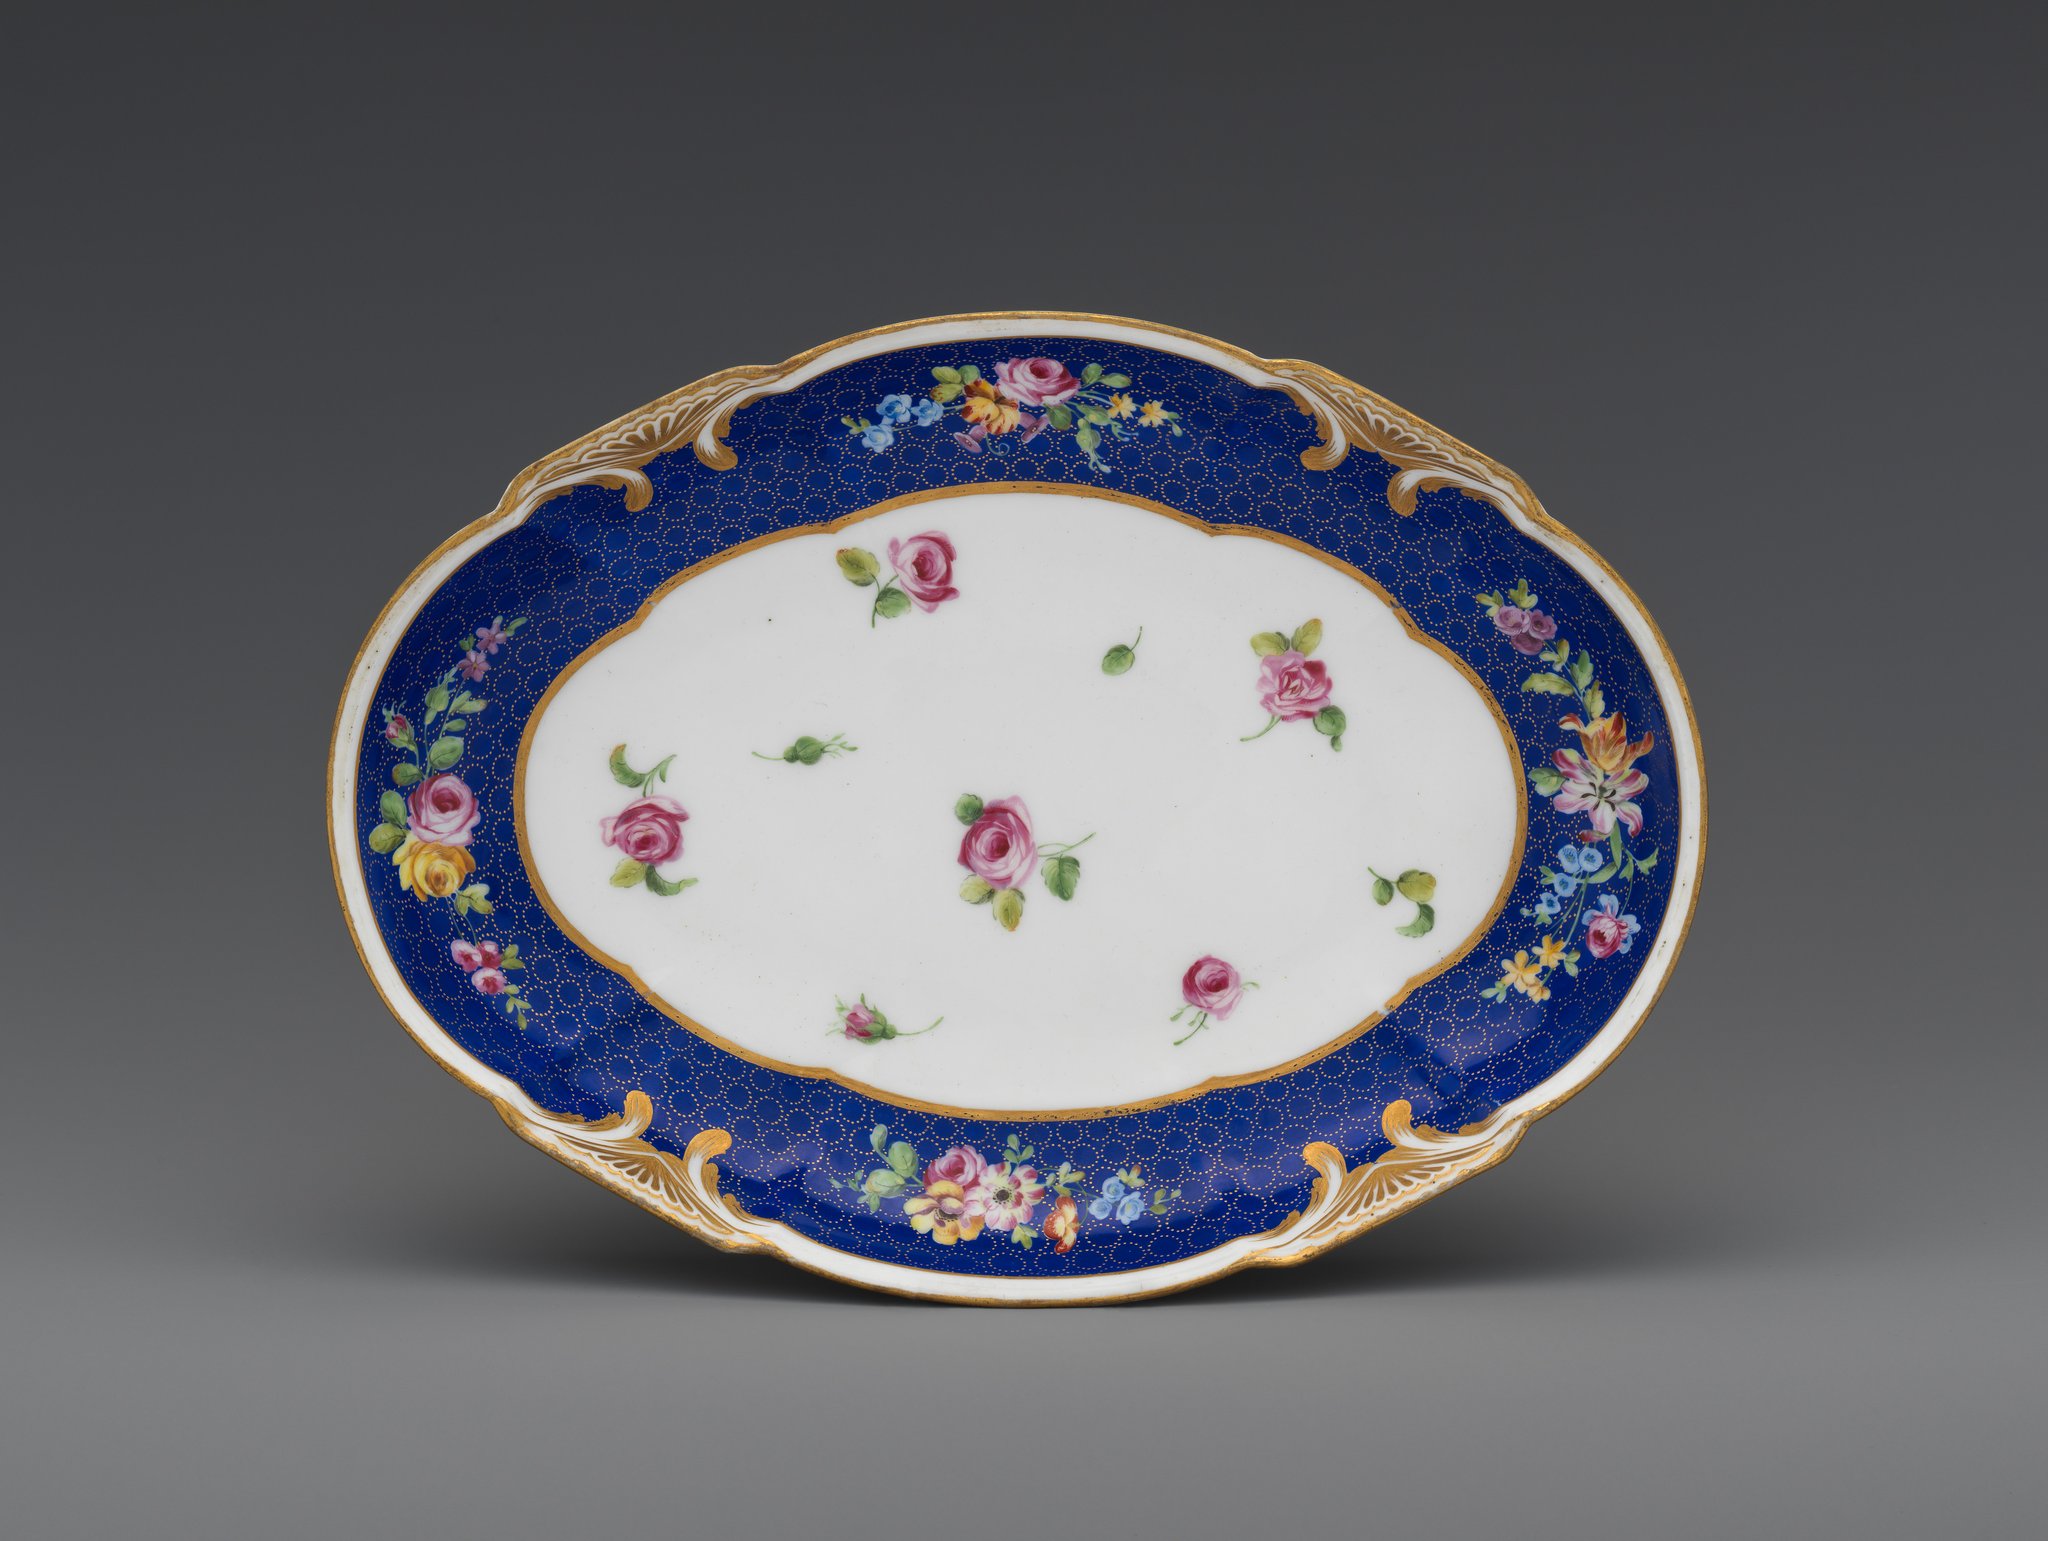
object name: platter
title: Oval platter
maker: sèvres manufactory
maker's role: manufactory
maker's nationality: french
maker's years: 1740-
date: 1771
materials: soft paste porcelain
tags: roses